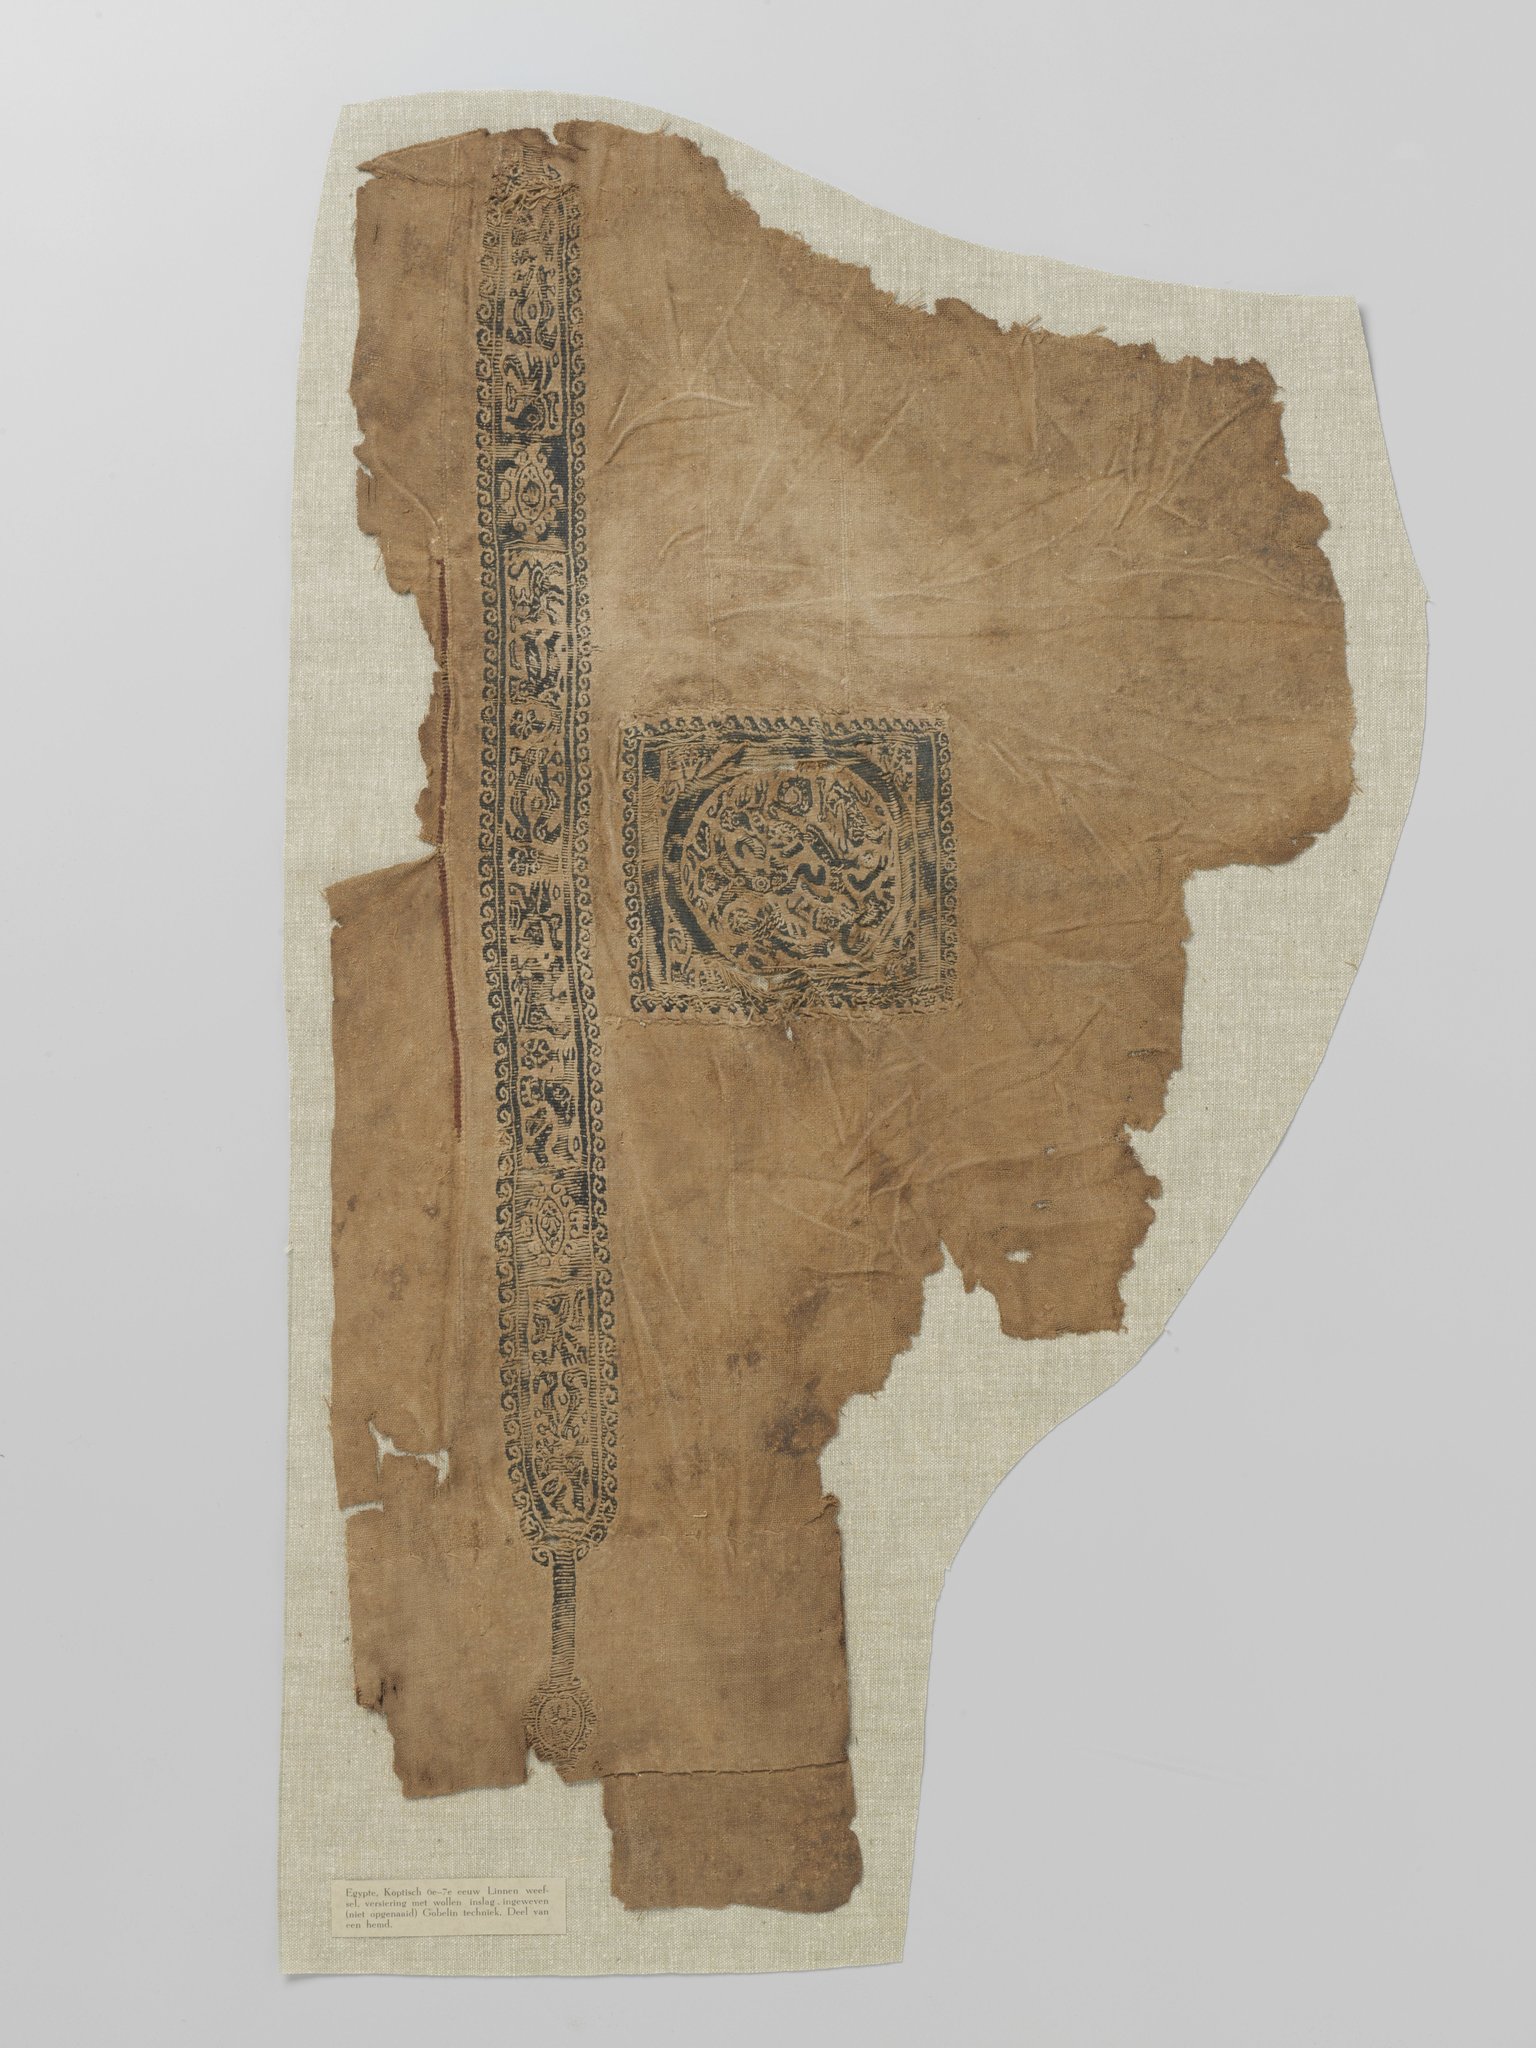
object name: tunicle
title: Fragment van een tunica met tabula en clavus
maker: Anonymous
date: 600-899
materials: linen, wool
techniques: weave, tapestry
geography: egypt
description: Linnen fragment van een tunica met ingeweven tabula en clavus in zwart. De clavus heeft een decoratie van dieren, o.a. lopende en springende leeuw, een zwevende figuuren een van elkaar afgewend vogelpaar. De clavus eindigt in een druppelvorm. In de tabula een cirkel waarin een met gekruiste benen dansende figuur met sluier boven het hoofd (nereïde?), alsmede enkele dieren w.o. een lopende leeuw en een slang. Aan de bovenzijde een dikkere inslag en een wollen donkerbruine inslag en is een deel van een zelfkant aanwezig. Dit duidt mogelijk op een halsuitsnijding. Aan de linker zijde is een weefselfragment aangenaaid dat voor het grootste gedeelte onder het grote fragment is bevestigd. Restanten van een soortgelijk fragment bevinden zich aan de rechter zijde.